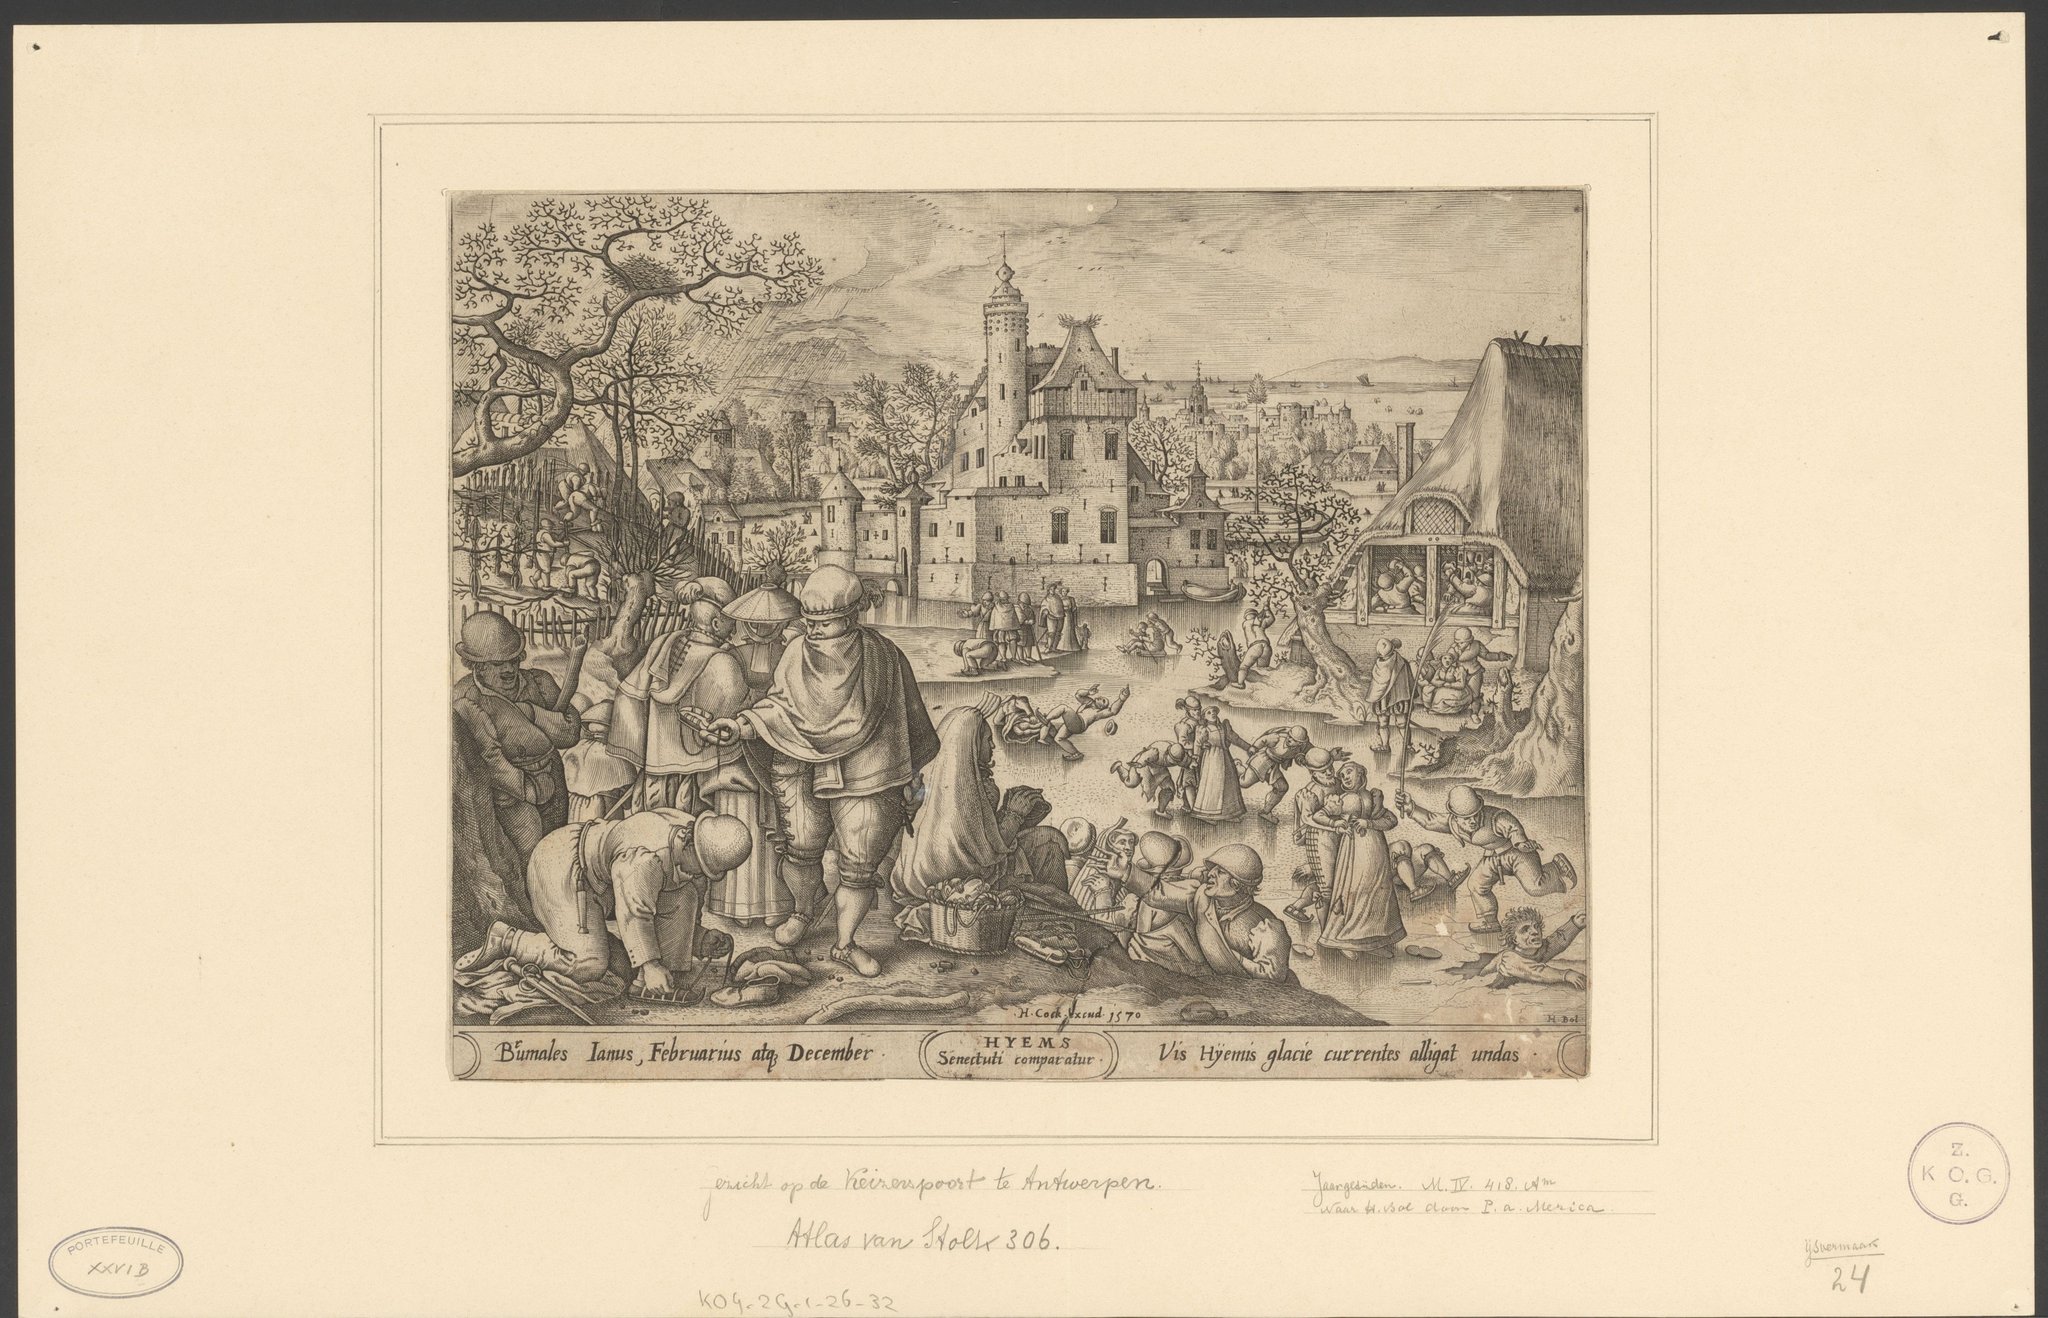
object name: print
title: Hyems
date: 1570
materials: paper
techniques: engraving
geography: antwerp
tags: winter, 'hyems'; 'inverno' (ripa) (+ with scenes showing human occupations ~ seasons and months), winter ~ human activities (the four seasons of the year), ice ~ freezing weather, skates (winter sports), severe winters, the four seasons of the year ~ human activities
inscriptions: collector's mark: Lugt 1641, collector's mark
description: In een weids landschap verrichten dorpelingen bezigheden die horen bij de maanden december, januari en februari. Bij een kasteel wordt plezier gemaakt op het ijs. Onder de voorstelling de titel met aan weerszijden daarvan twee regels in het Latijn. Prent uit een serie van vier prenten met voorstellingen van de vier seizoenen. Onderwerpsrubrieken binnen de Atlas Zeden en Gewoonten: Spel en Vermaak; IJsvermaak, Jaargetijden.